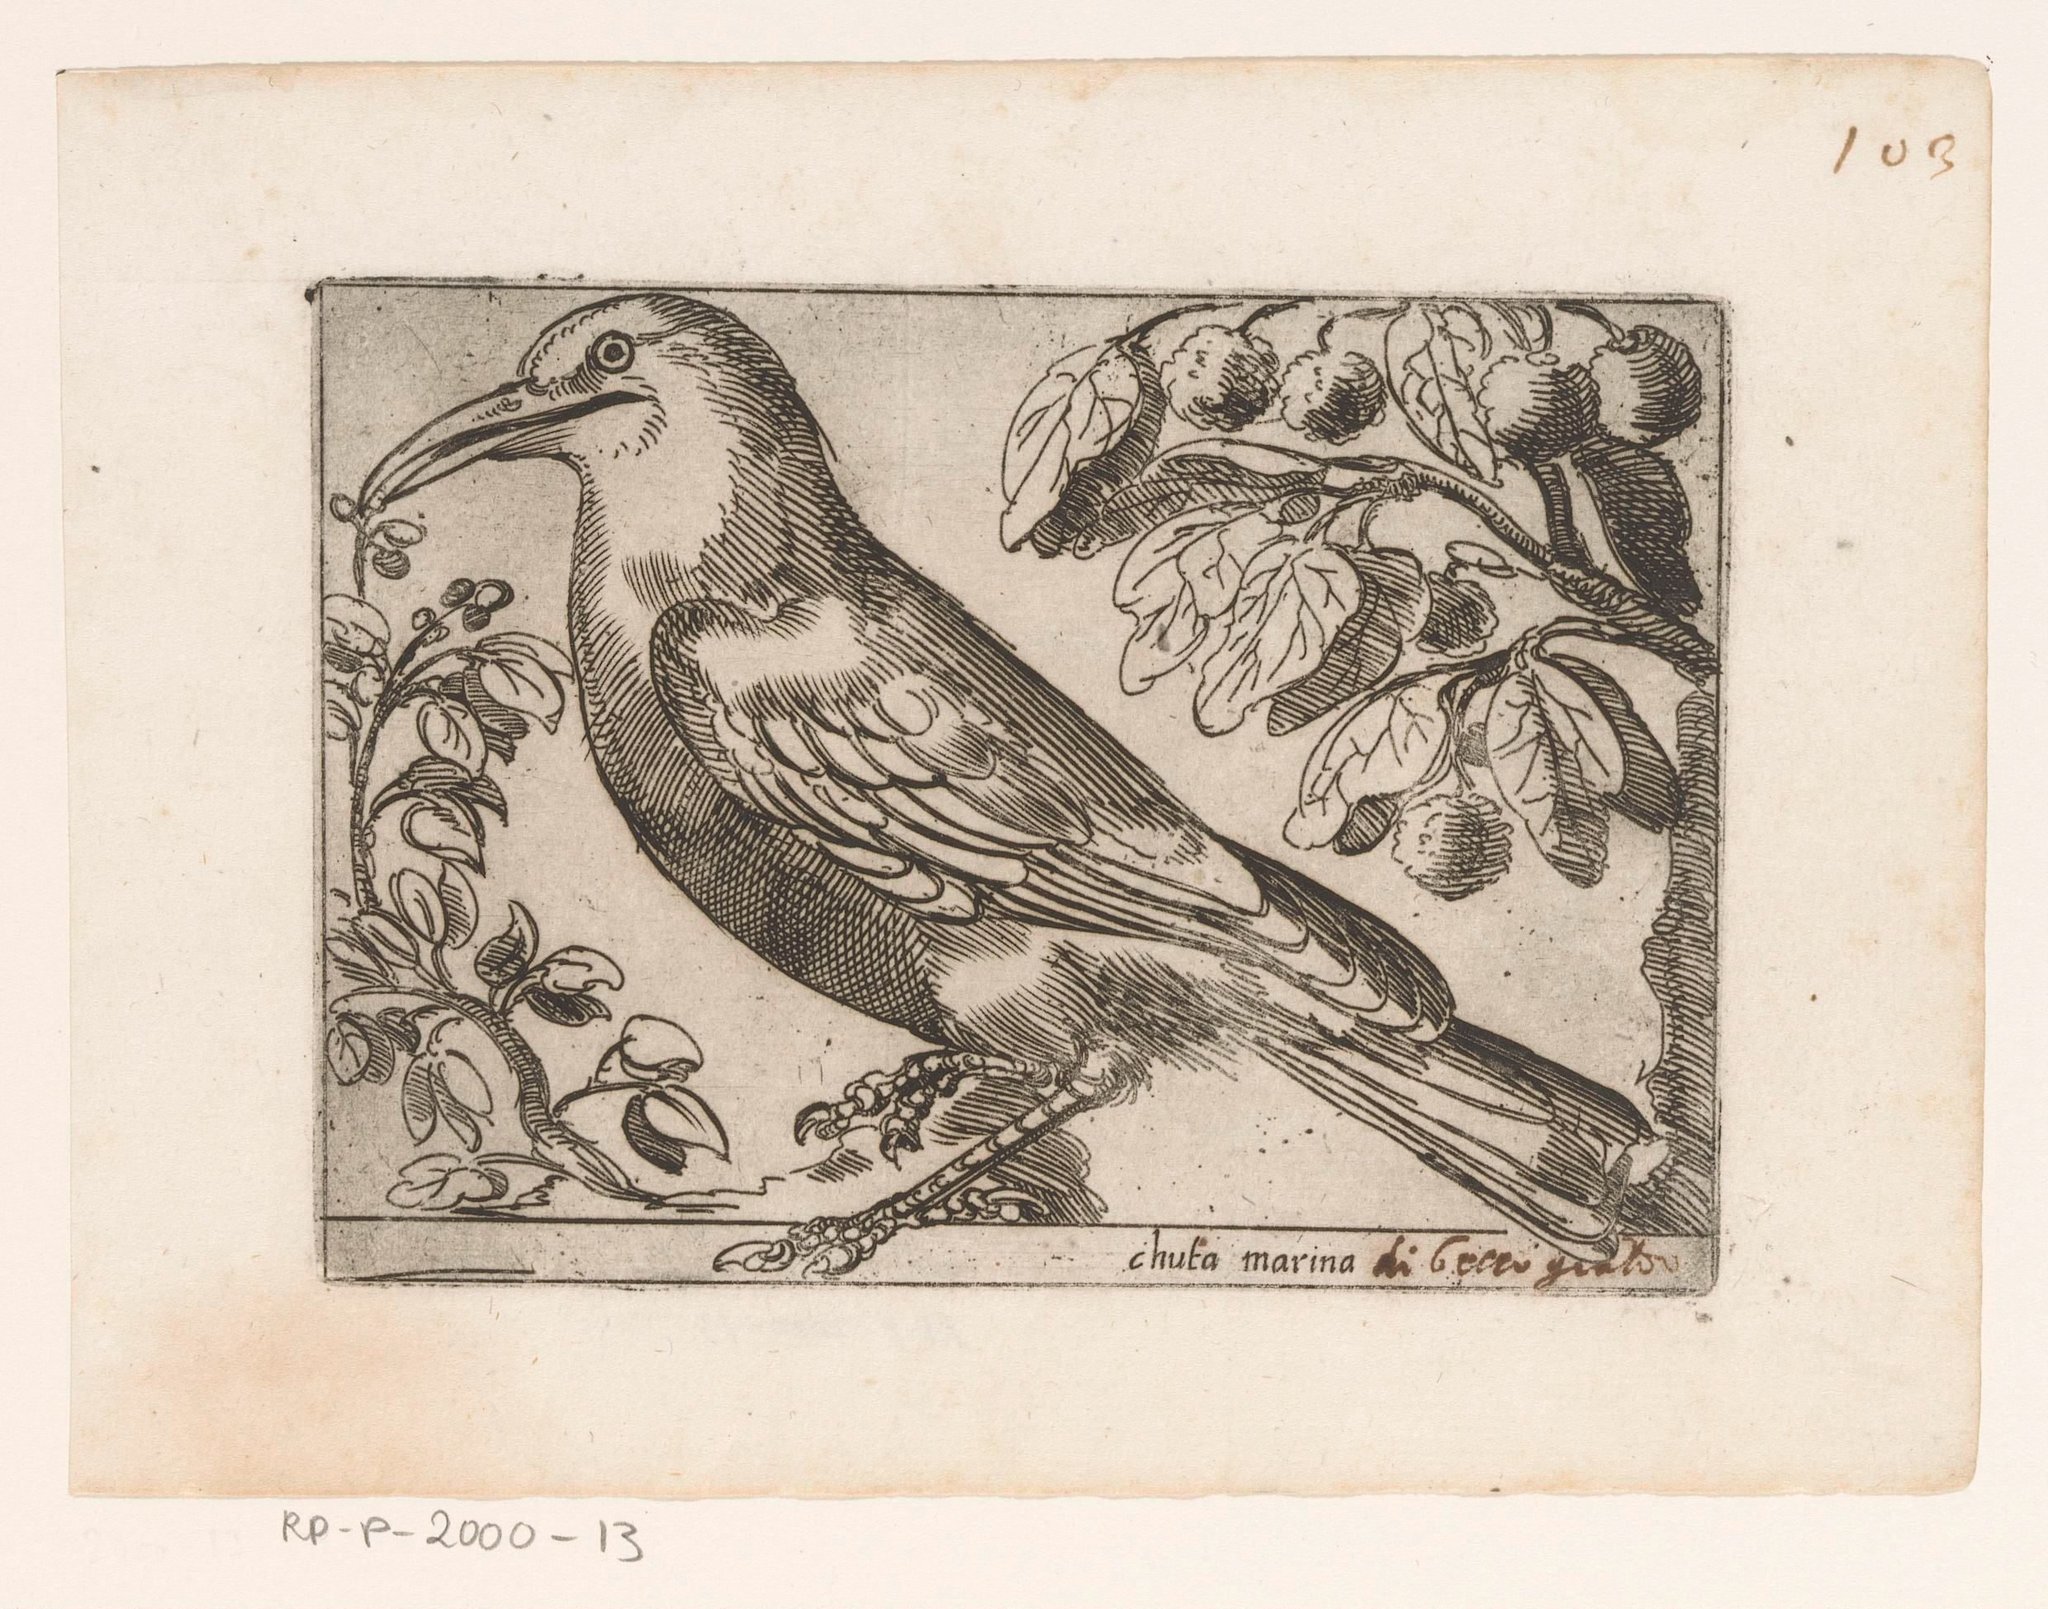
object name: print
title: Vogels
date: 1580-1590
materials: paper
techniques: etching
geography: italy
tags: birds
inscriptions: inscription: ‘di Gecci gia[...]’, collector's mark: Lugt 2228, collector's mark: Lugt 2760, number: ‘103’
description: Deze prent maakt deel uit van een reeks prenten van vogels.